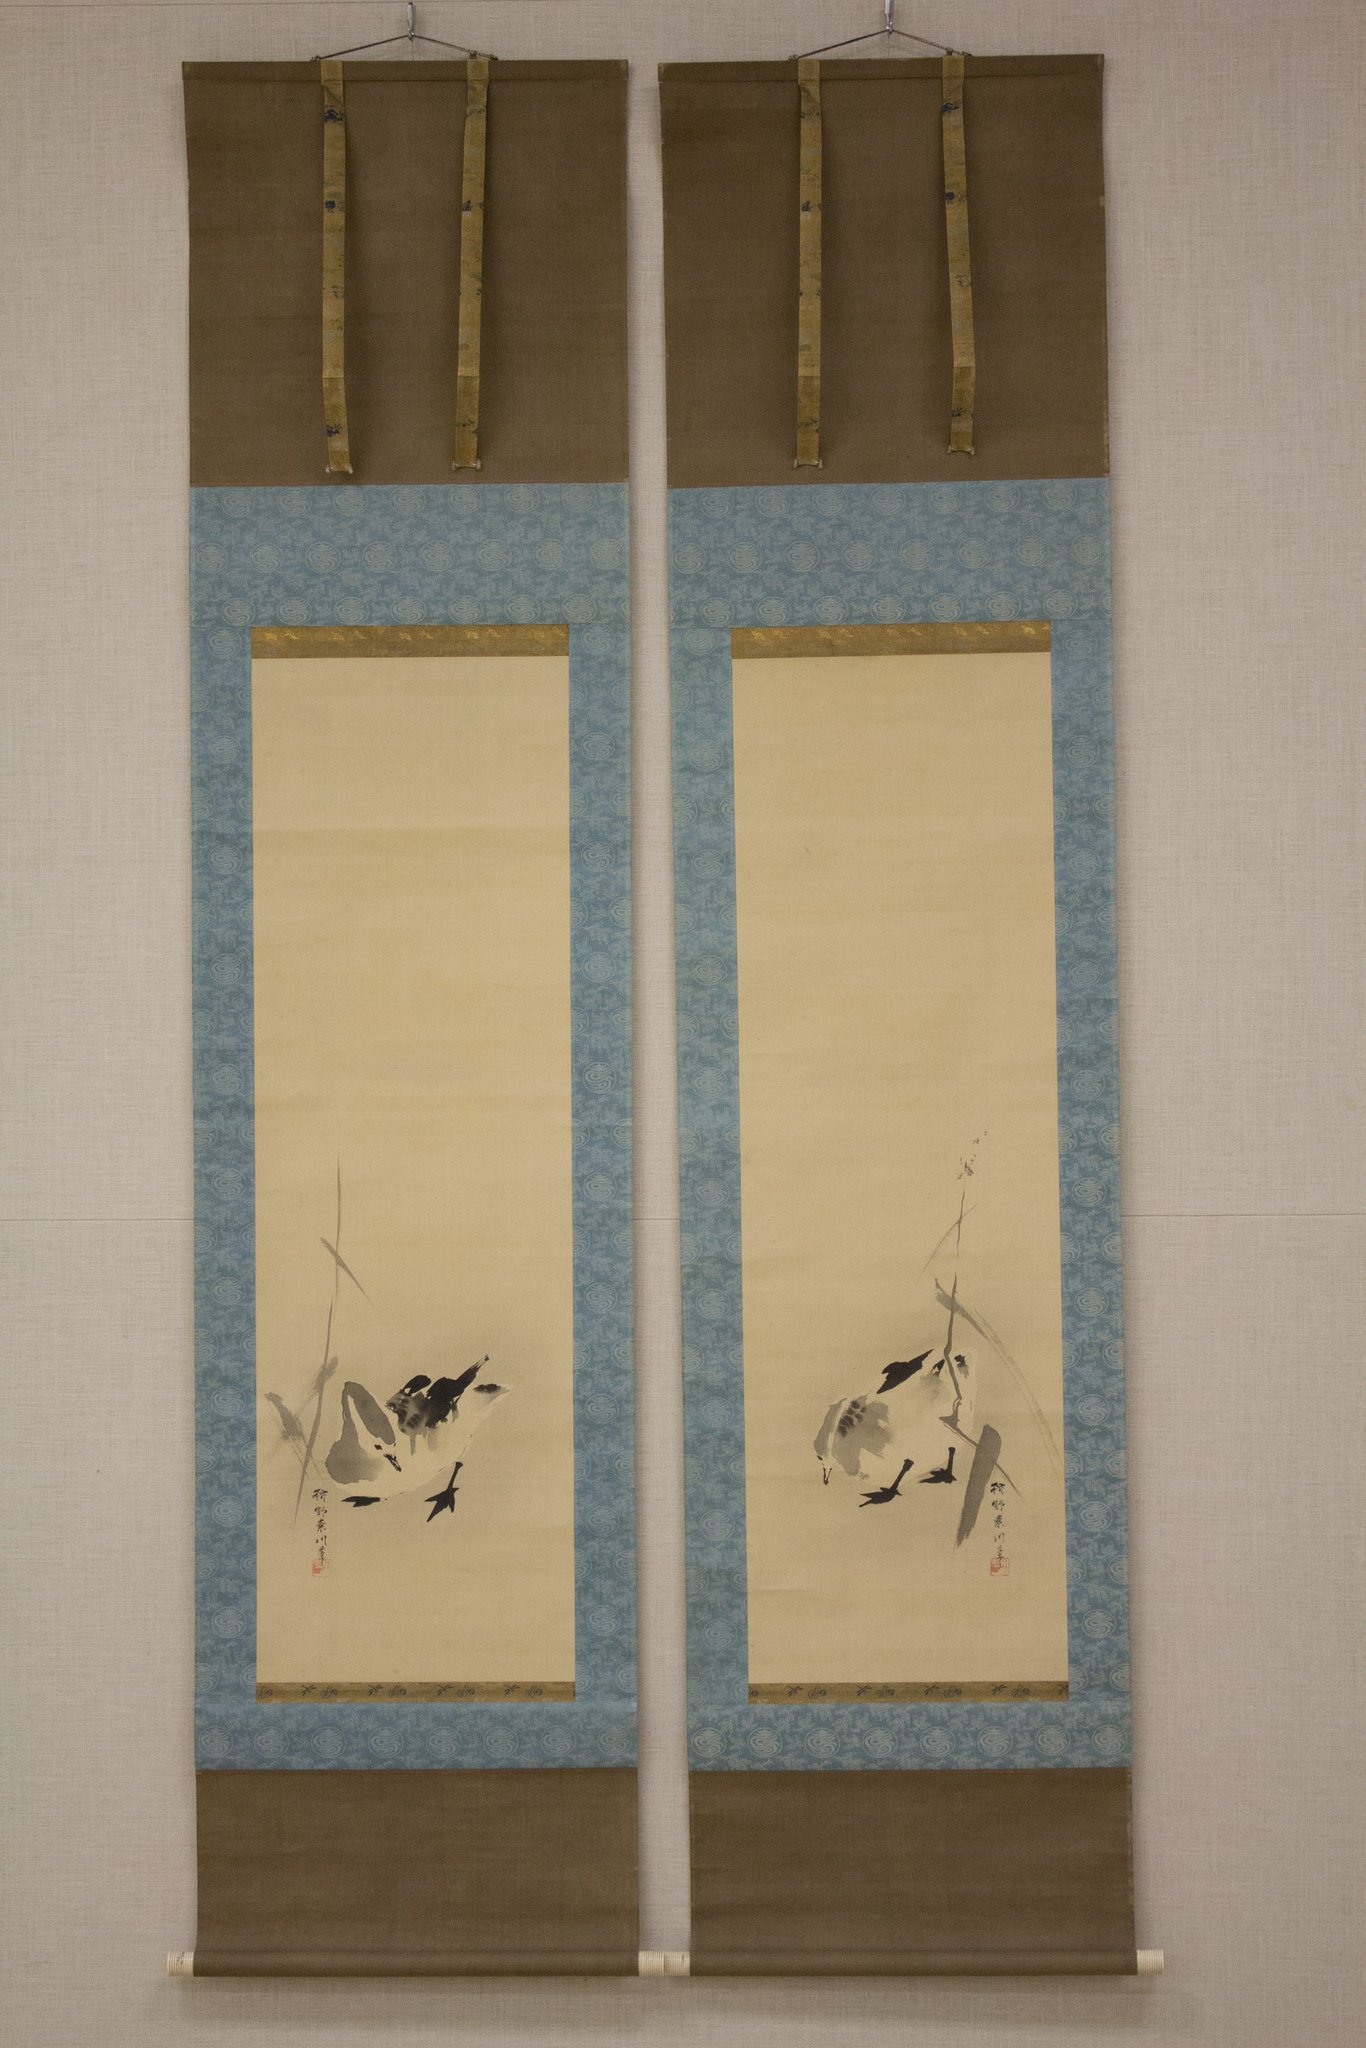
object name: hanging scroll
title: Geese and Reeds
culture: japanese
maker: kano sosen narinobu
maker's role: artist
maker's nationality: japanese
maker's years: 1813-1897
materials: ink, silk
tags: geese